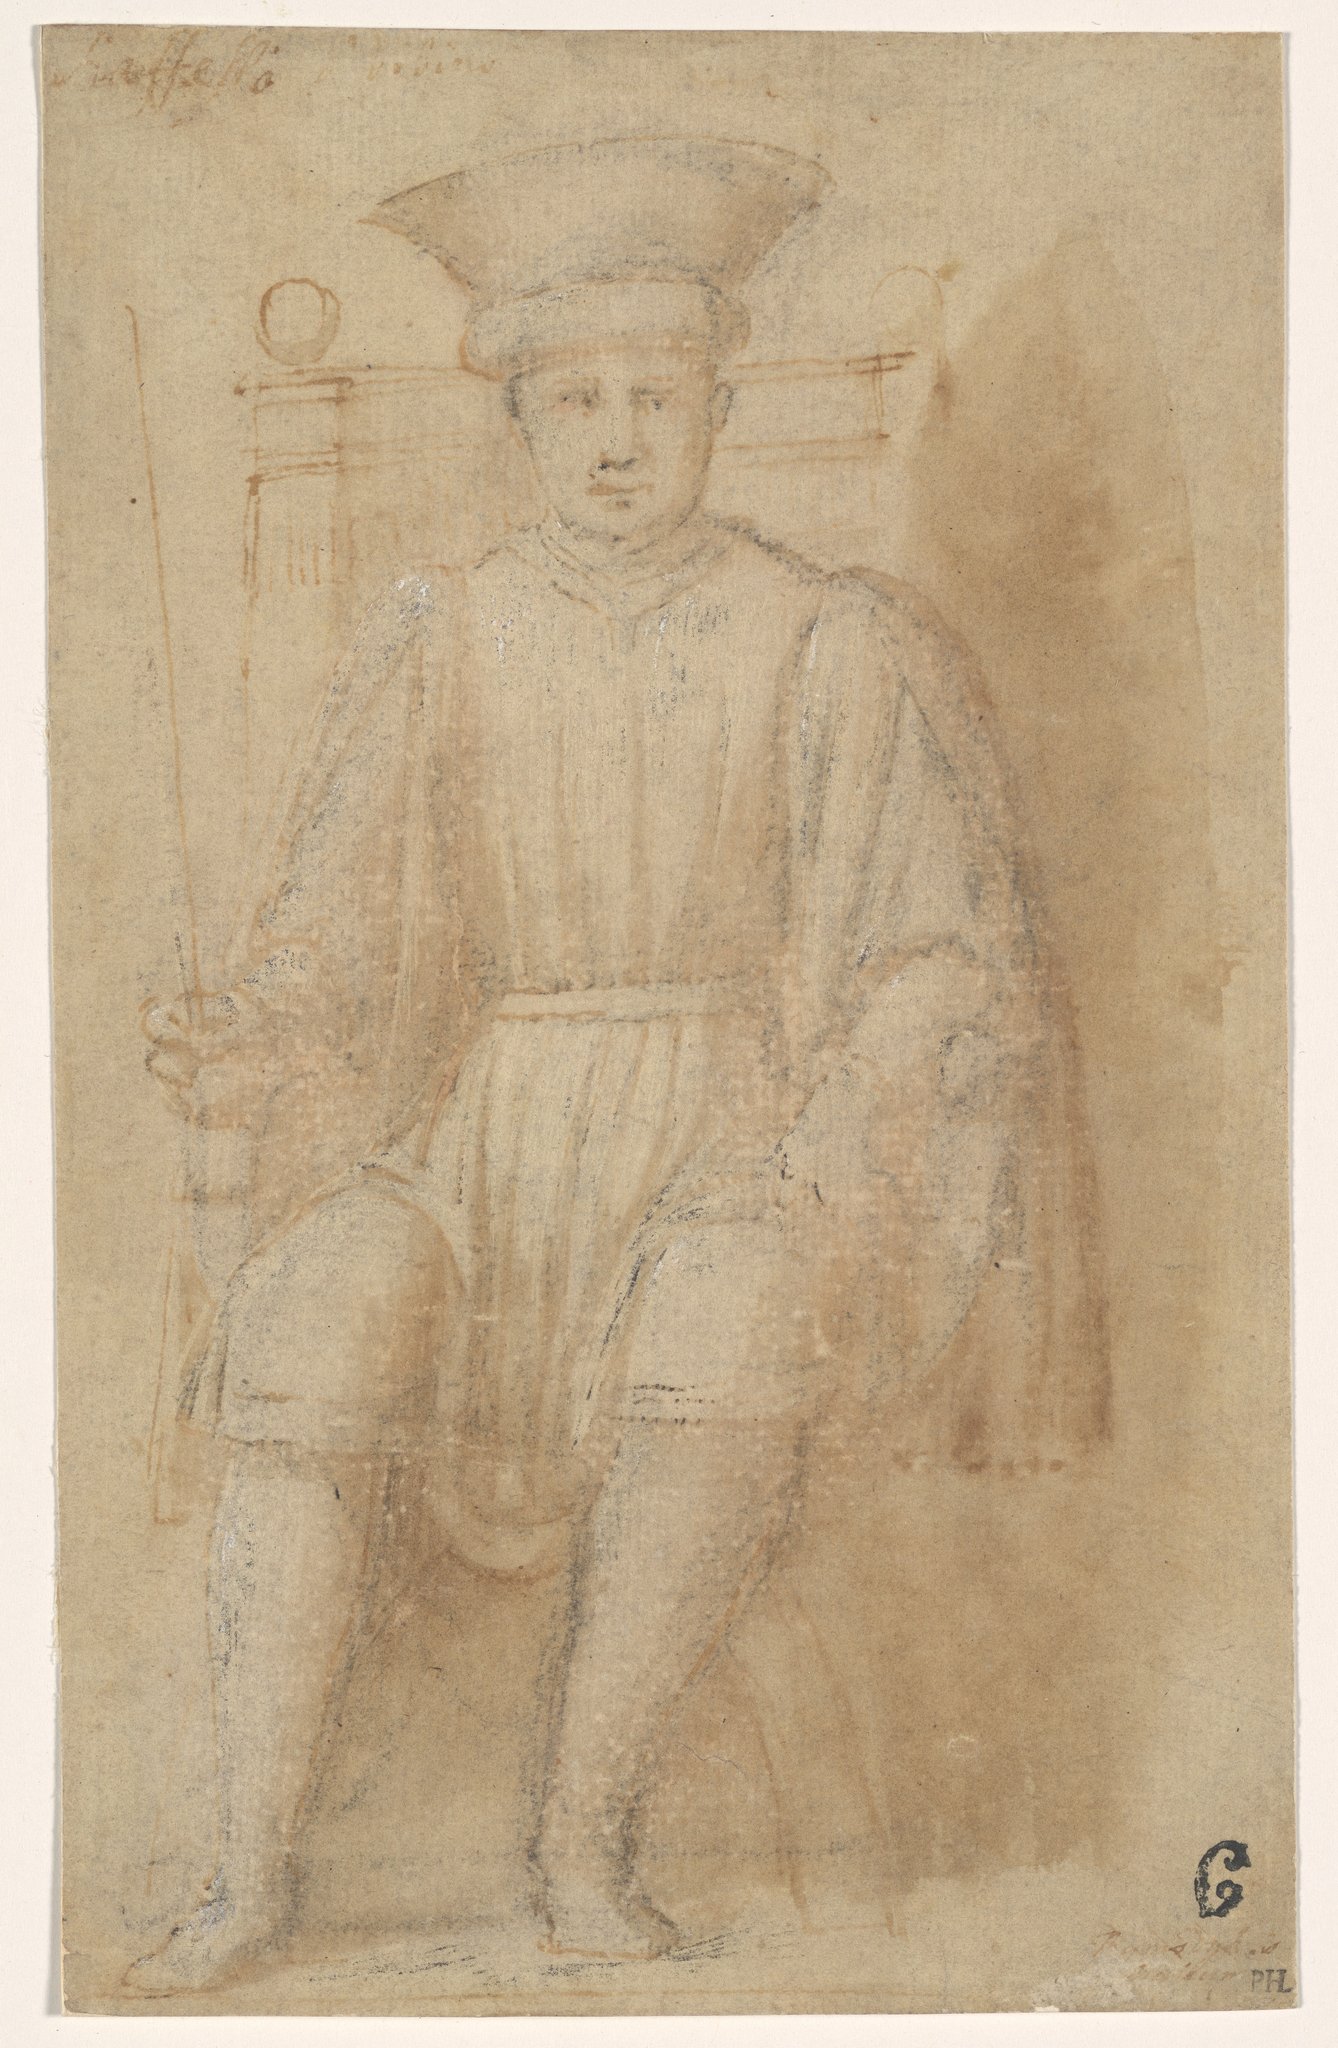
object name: drawing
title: A Man Seated on a Throne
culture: italian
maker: follower of piero della francesca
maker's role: artist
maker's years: 1415-1492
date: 1451-1500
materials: chalk, ink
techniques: brush, heightening, pen, wash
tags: men,portraits